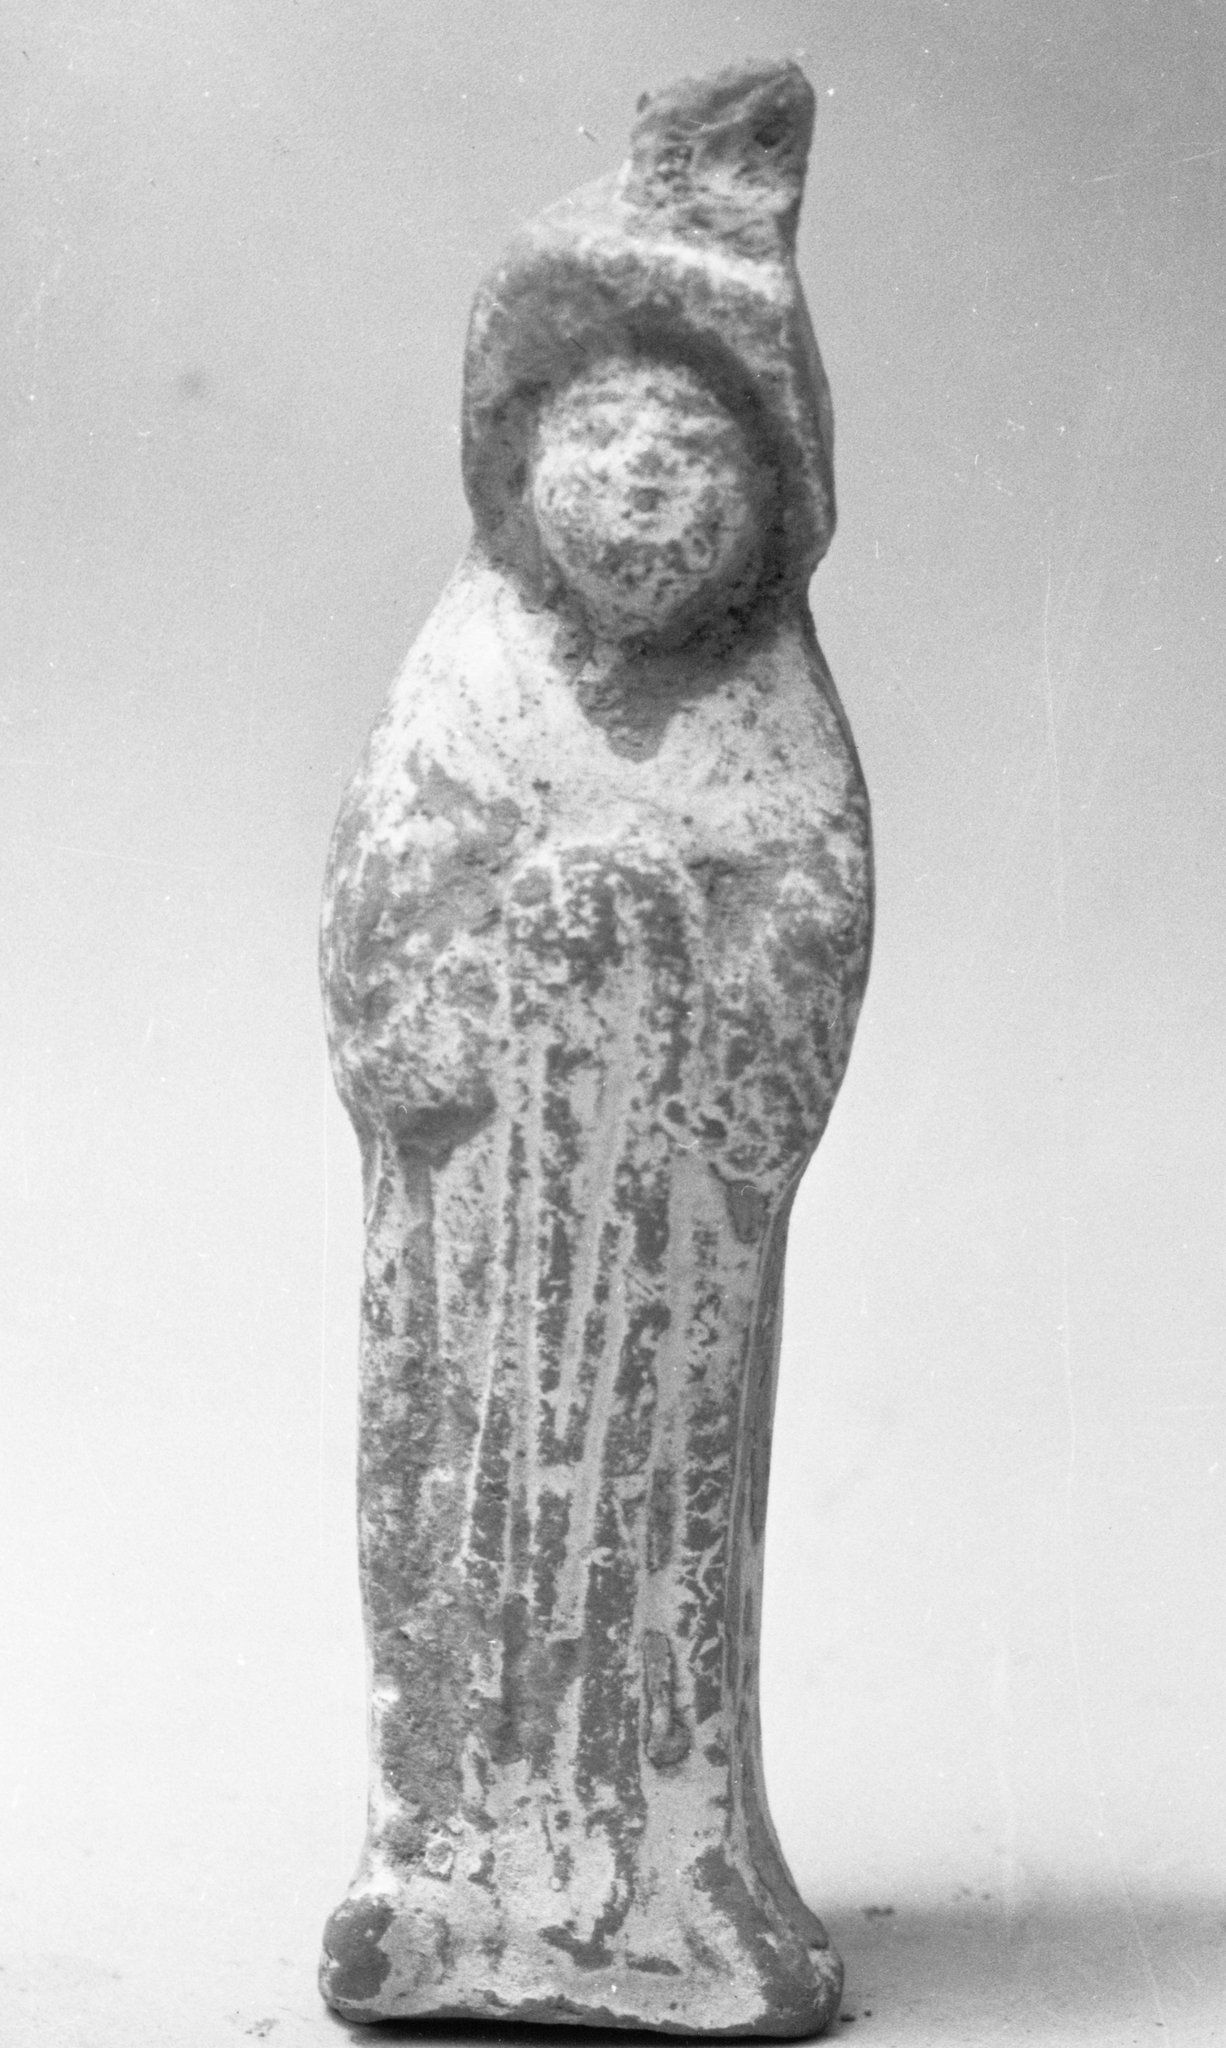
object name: figure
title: Court lady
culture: chinese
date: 601-800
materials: earthenware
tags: women